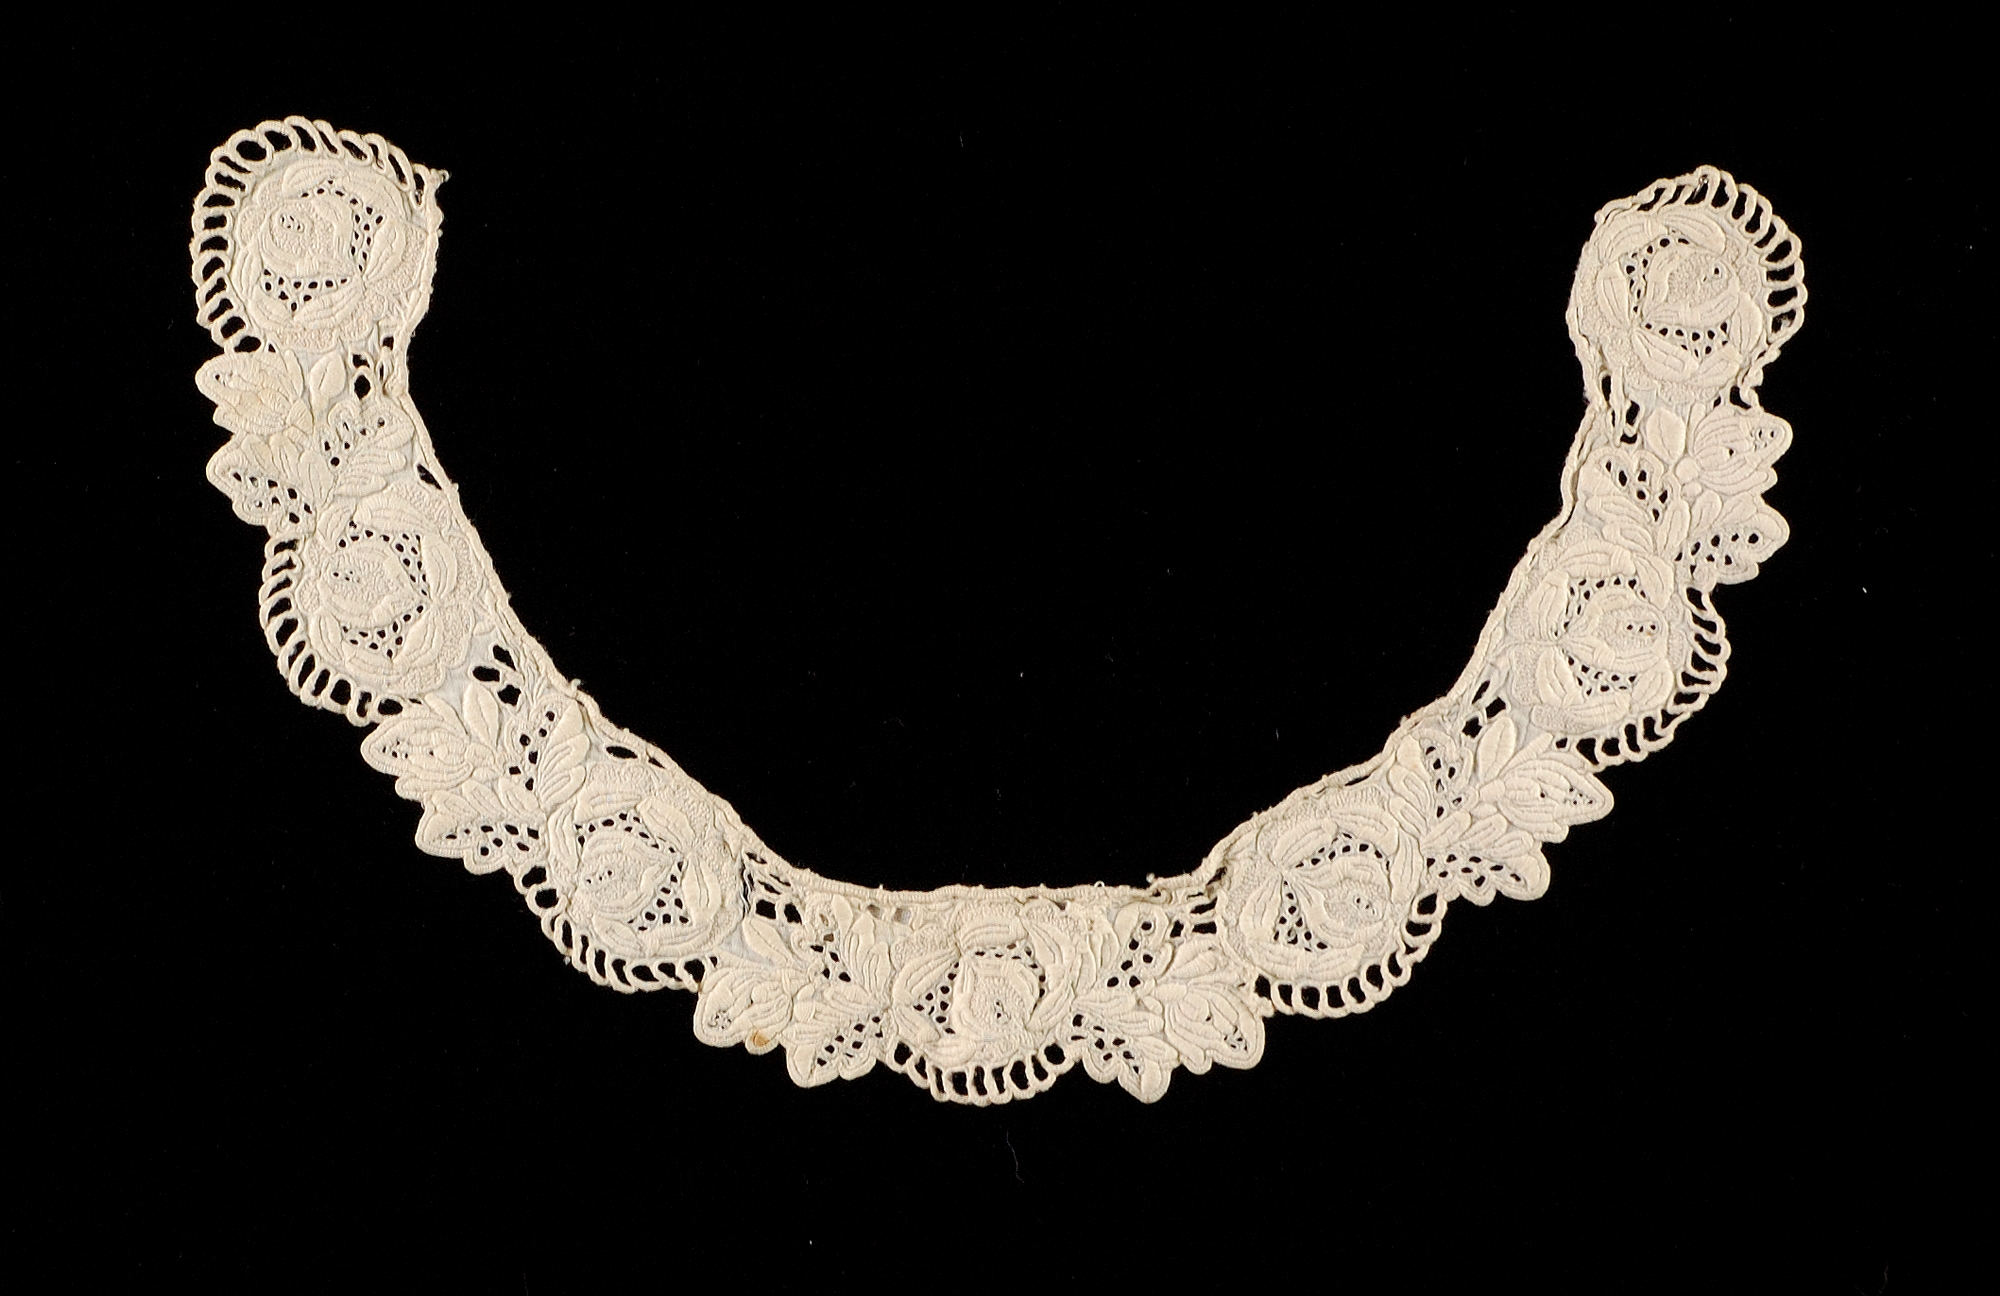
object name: collar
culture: american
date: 1850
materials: cotton